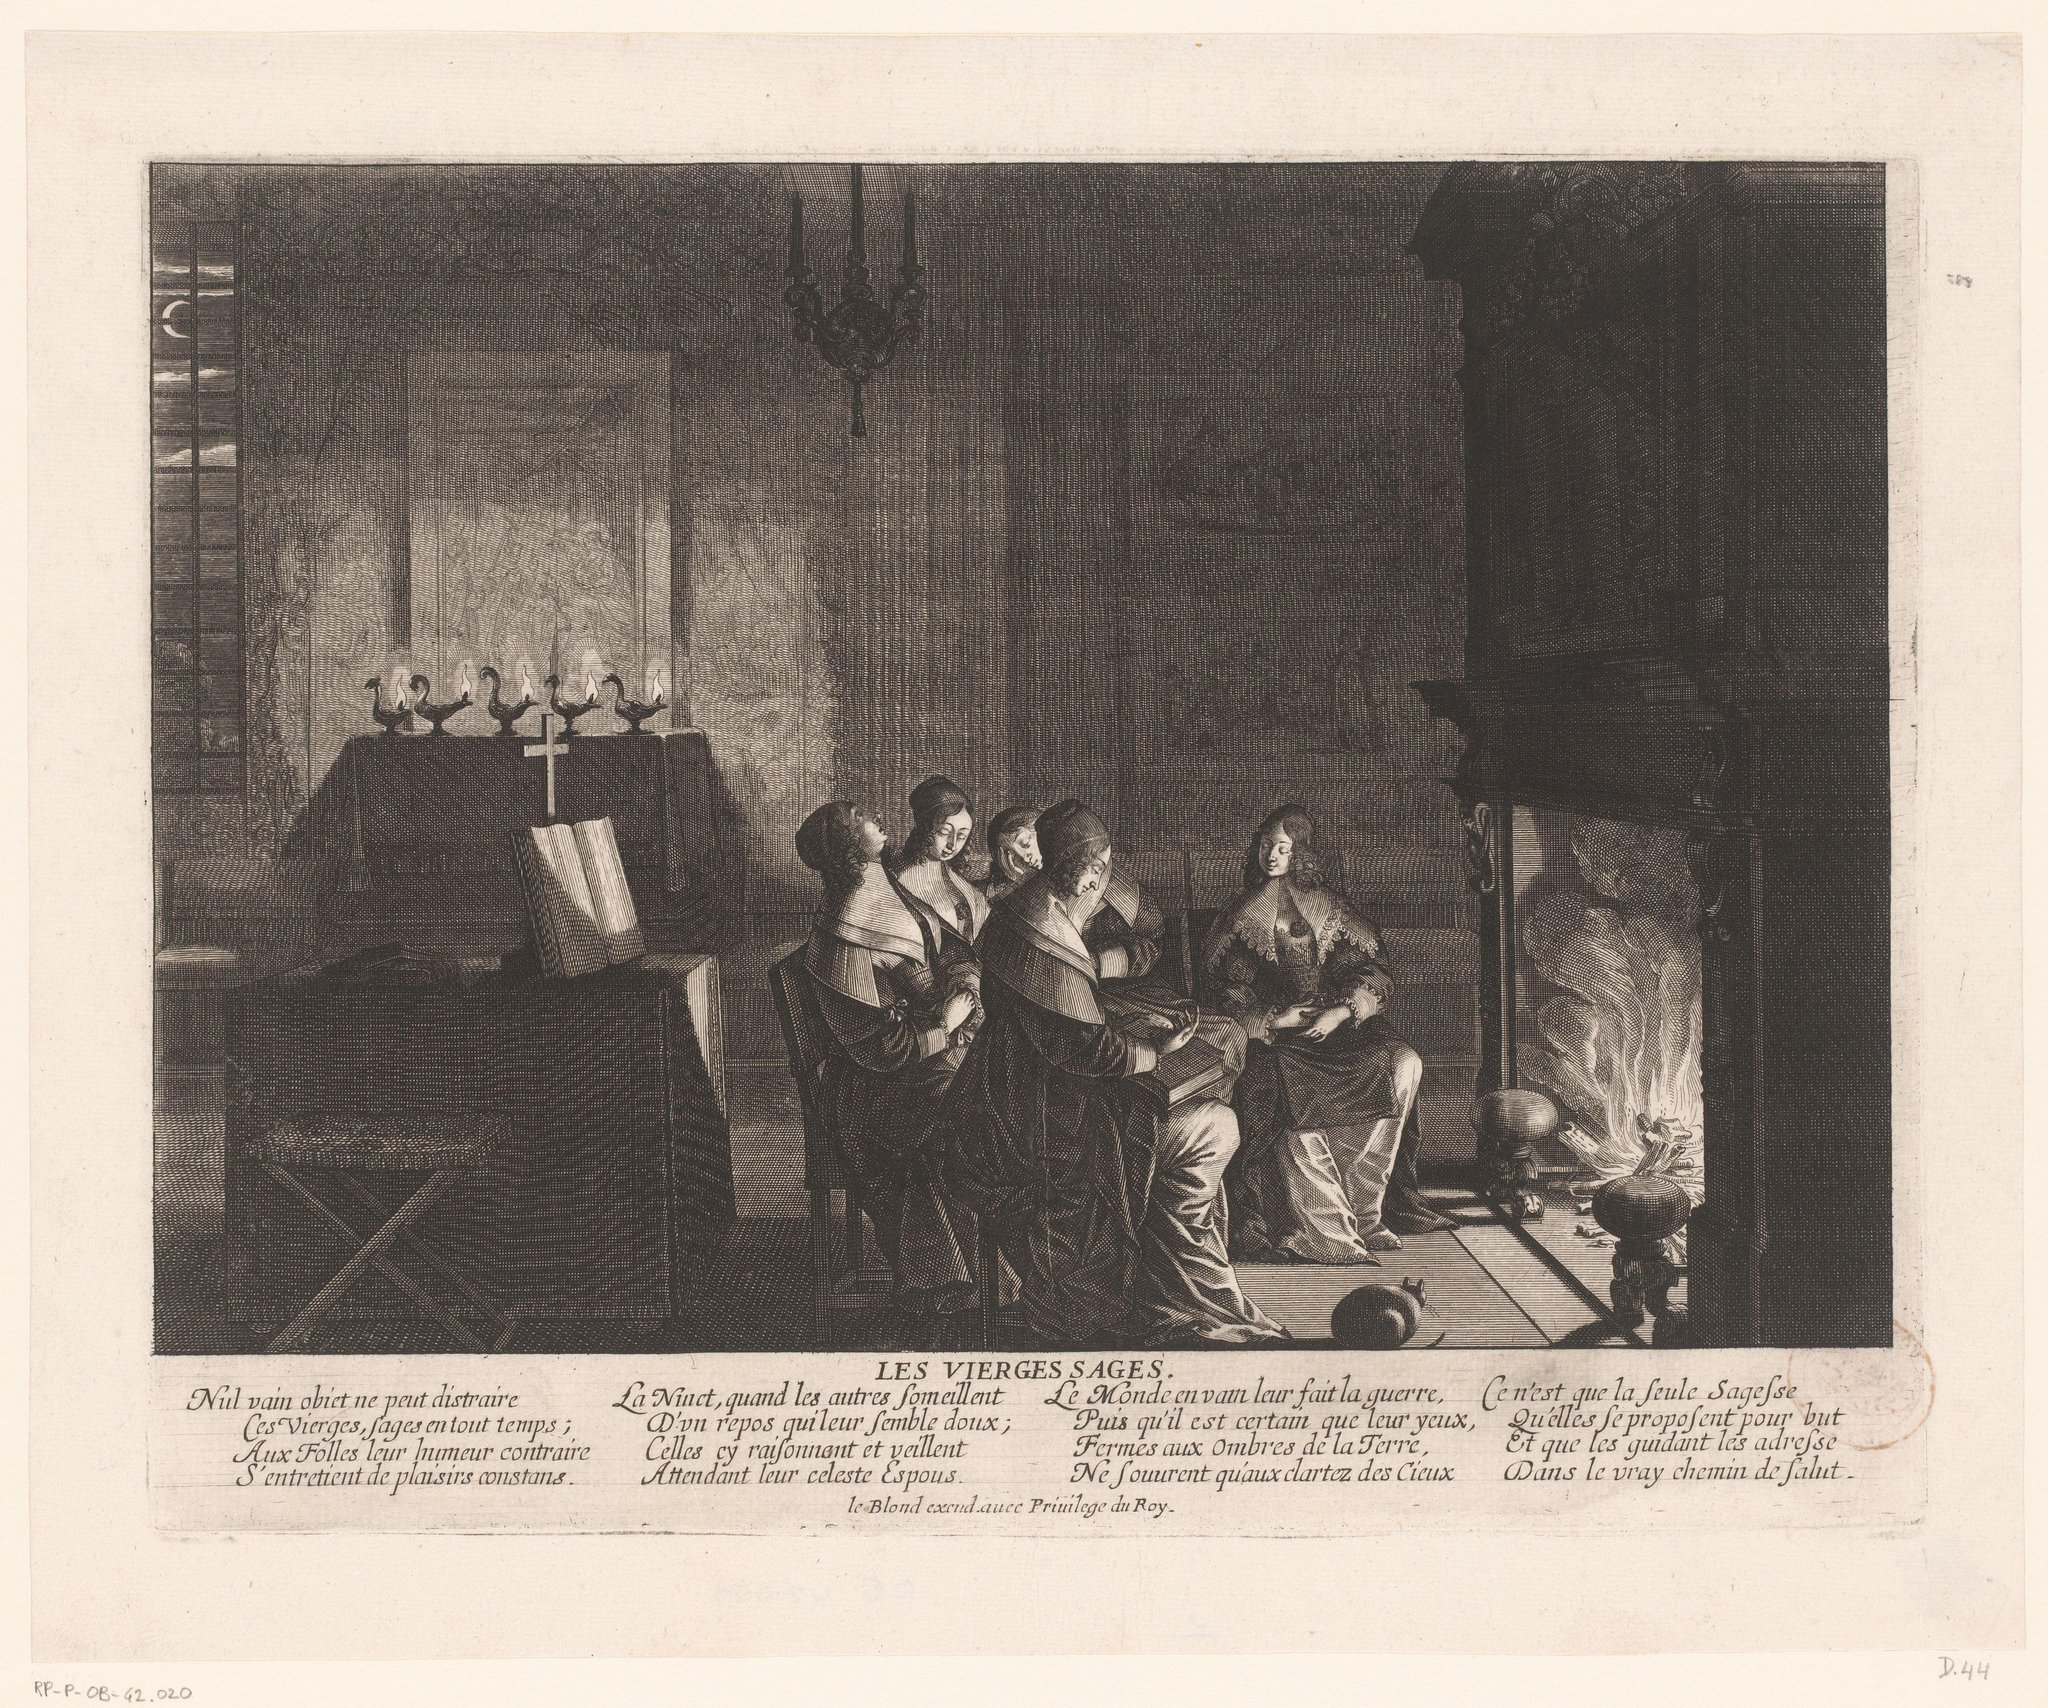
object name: print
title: Les Vierges Sages.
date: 1638-1640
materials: paper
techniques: engraving, etching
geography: paris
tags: the wise and the foolish virgins sleeping, sleeping in chair, the wise and the foolish virgins ~ parable of christ (matthew 25:1-13), open hearth, fire-place, oil-lamp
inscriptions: collector's mark: Lugt 240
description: Maakt deel uit van een serie van zeven prenten met als onderwerp de parabel van de vijf wijze en de vijf dwaze maagden. De eerste staat werd uitgegeven door Jean Leblond (I) en een tweede staat door de weduwe van Poilly.